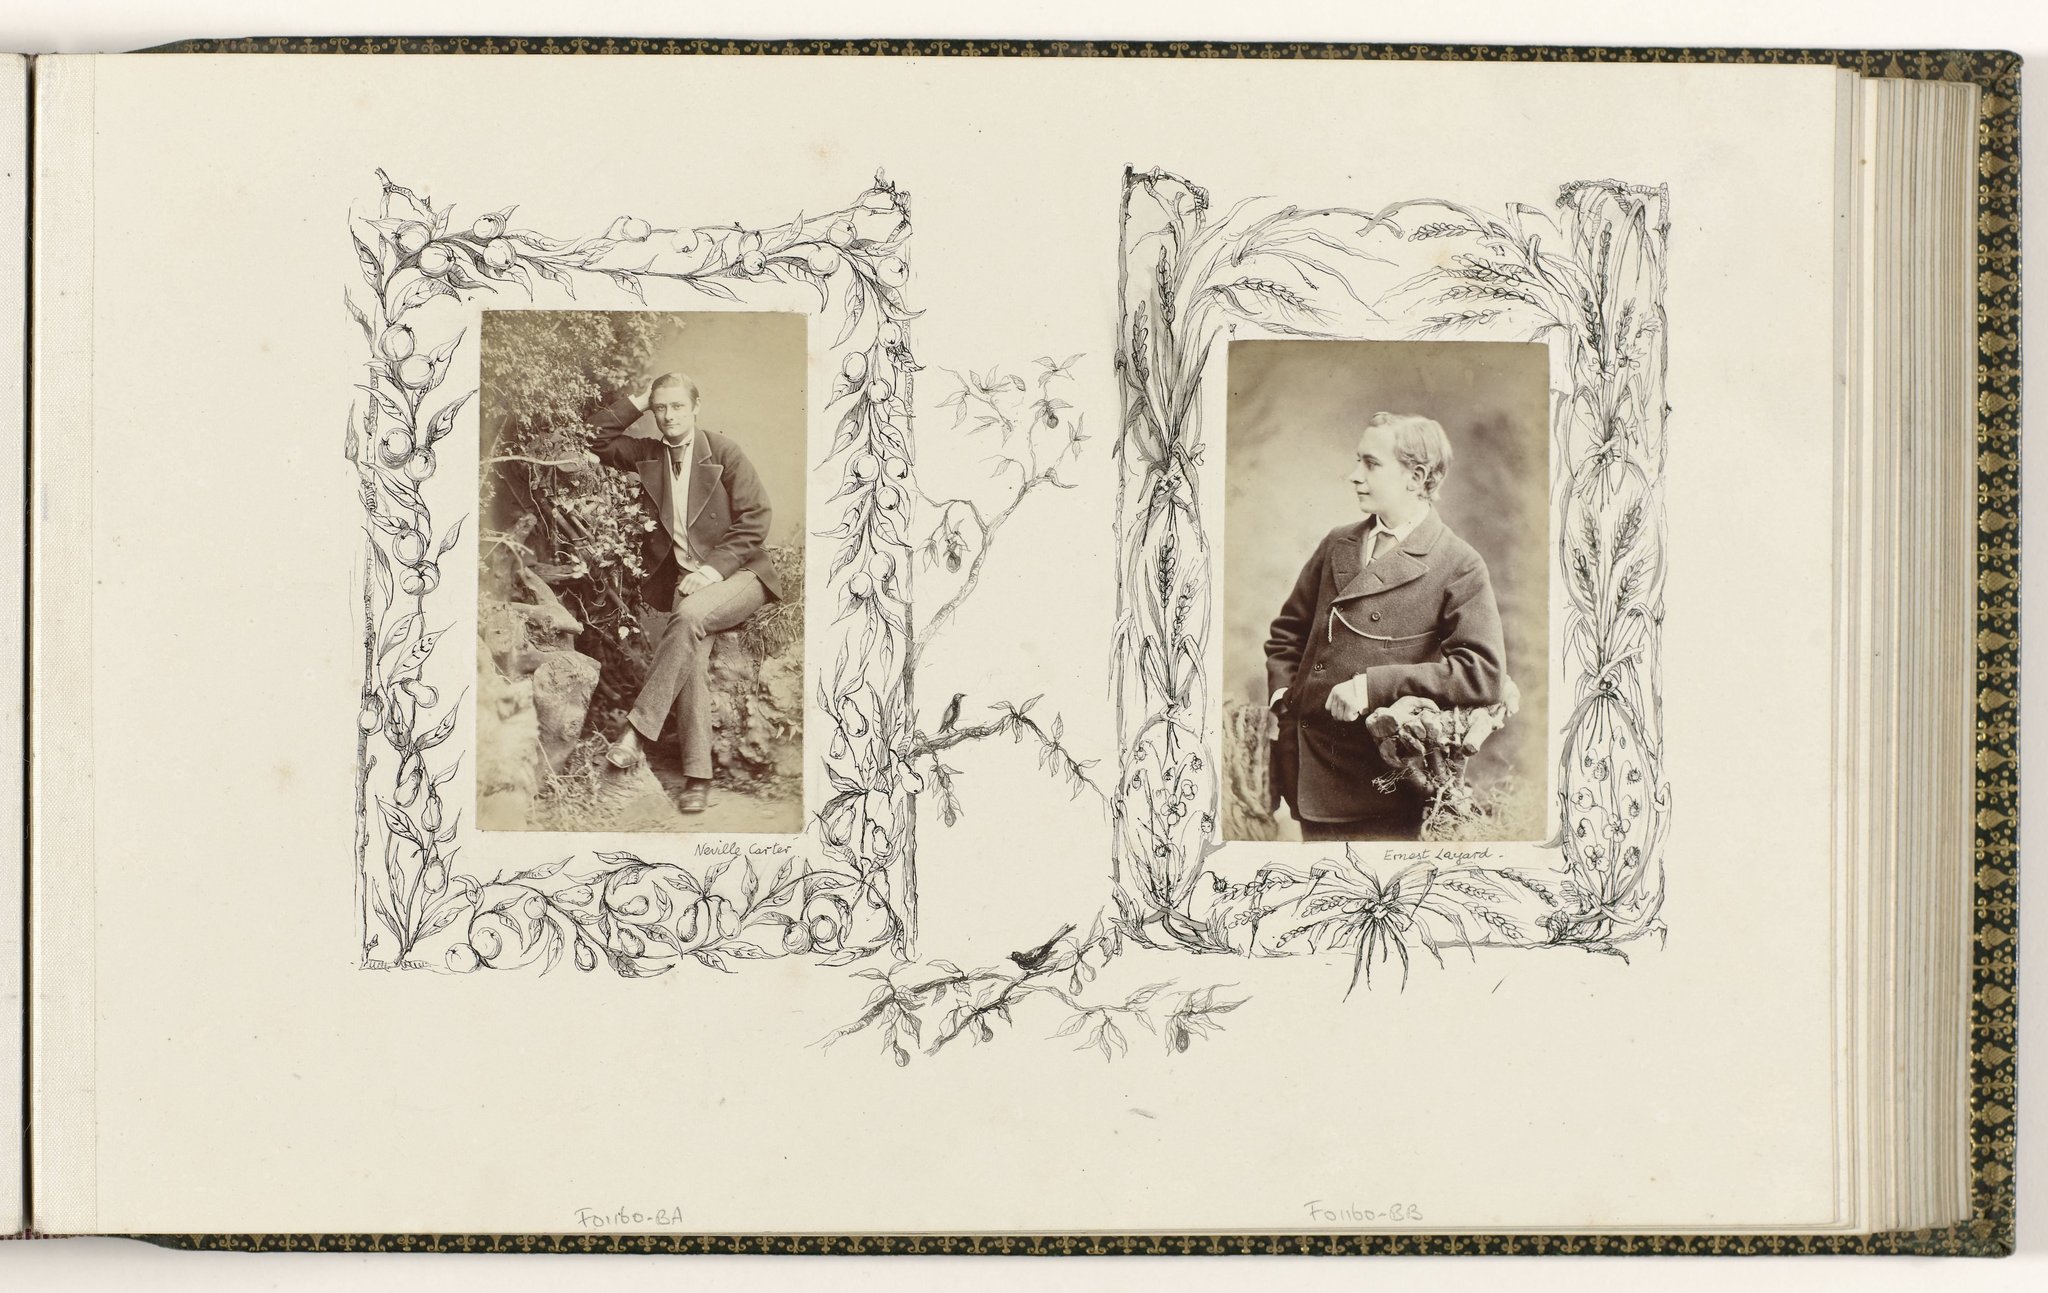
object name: photograph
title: Portret van Ernest Layard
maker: Anonymous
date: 1865-1880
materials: paper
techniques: albumen print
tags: historical persons, youth, adolescent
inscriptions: inscription: ‘Ernest Layard’